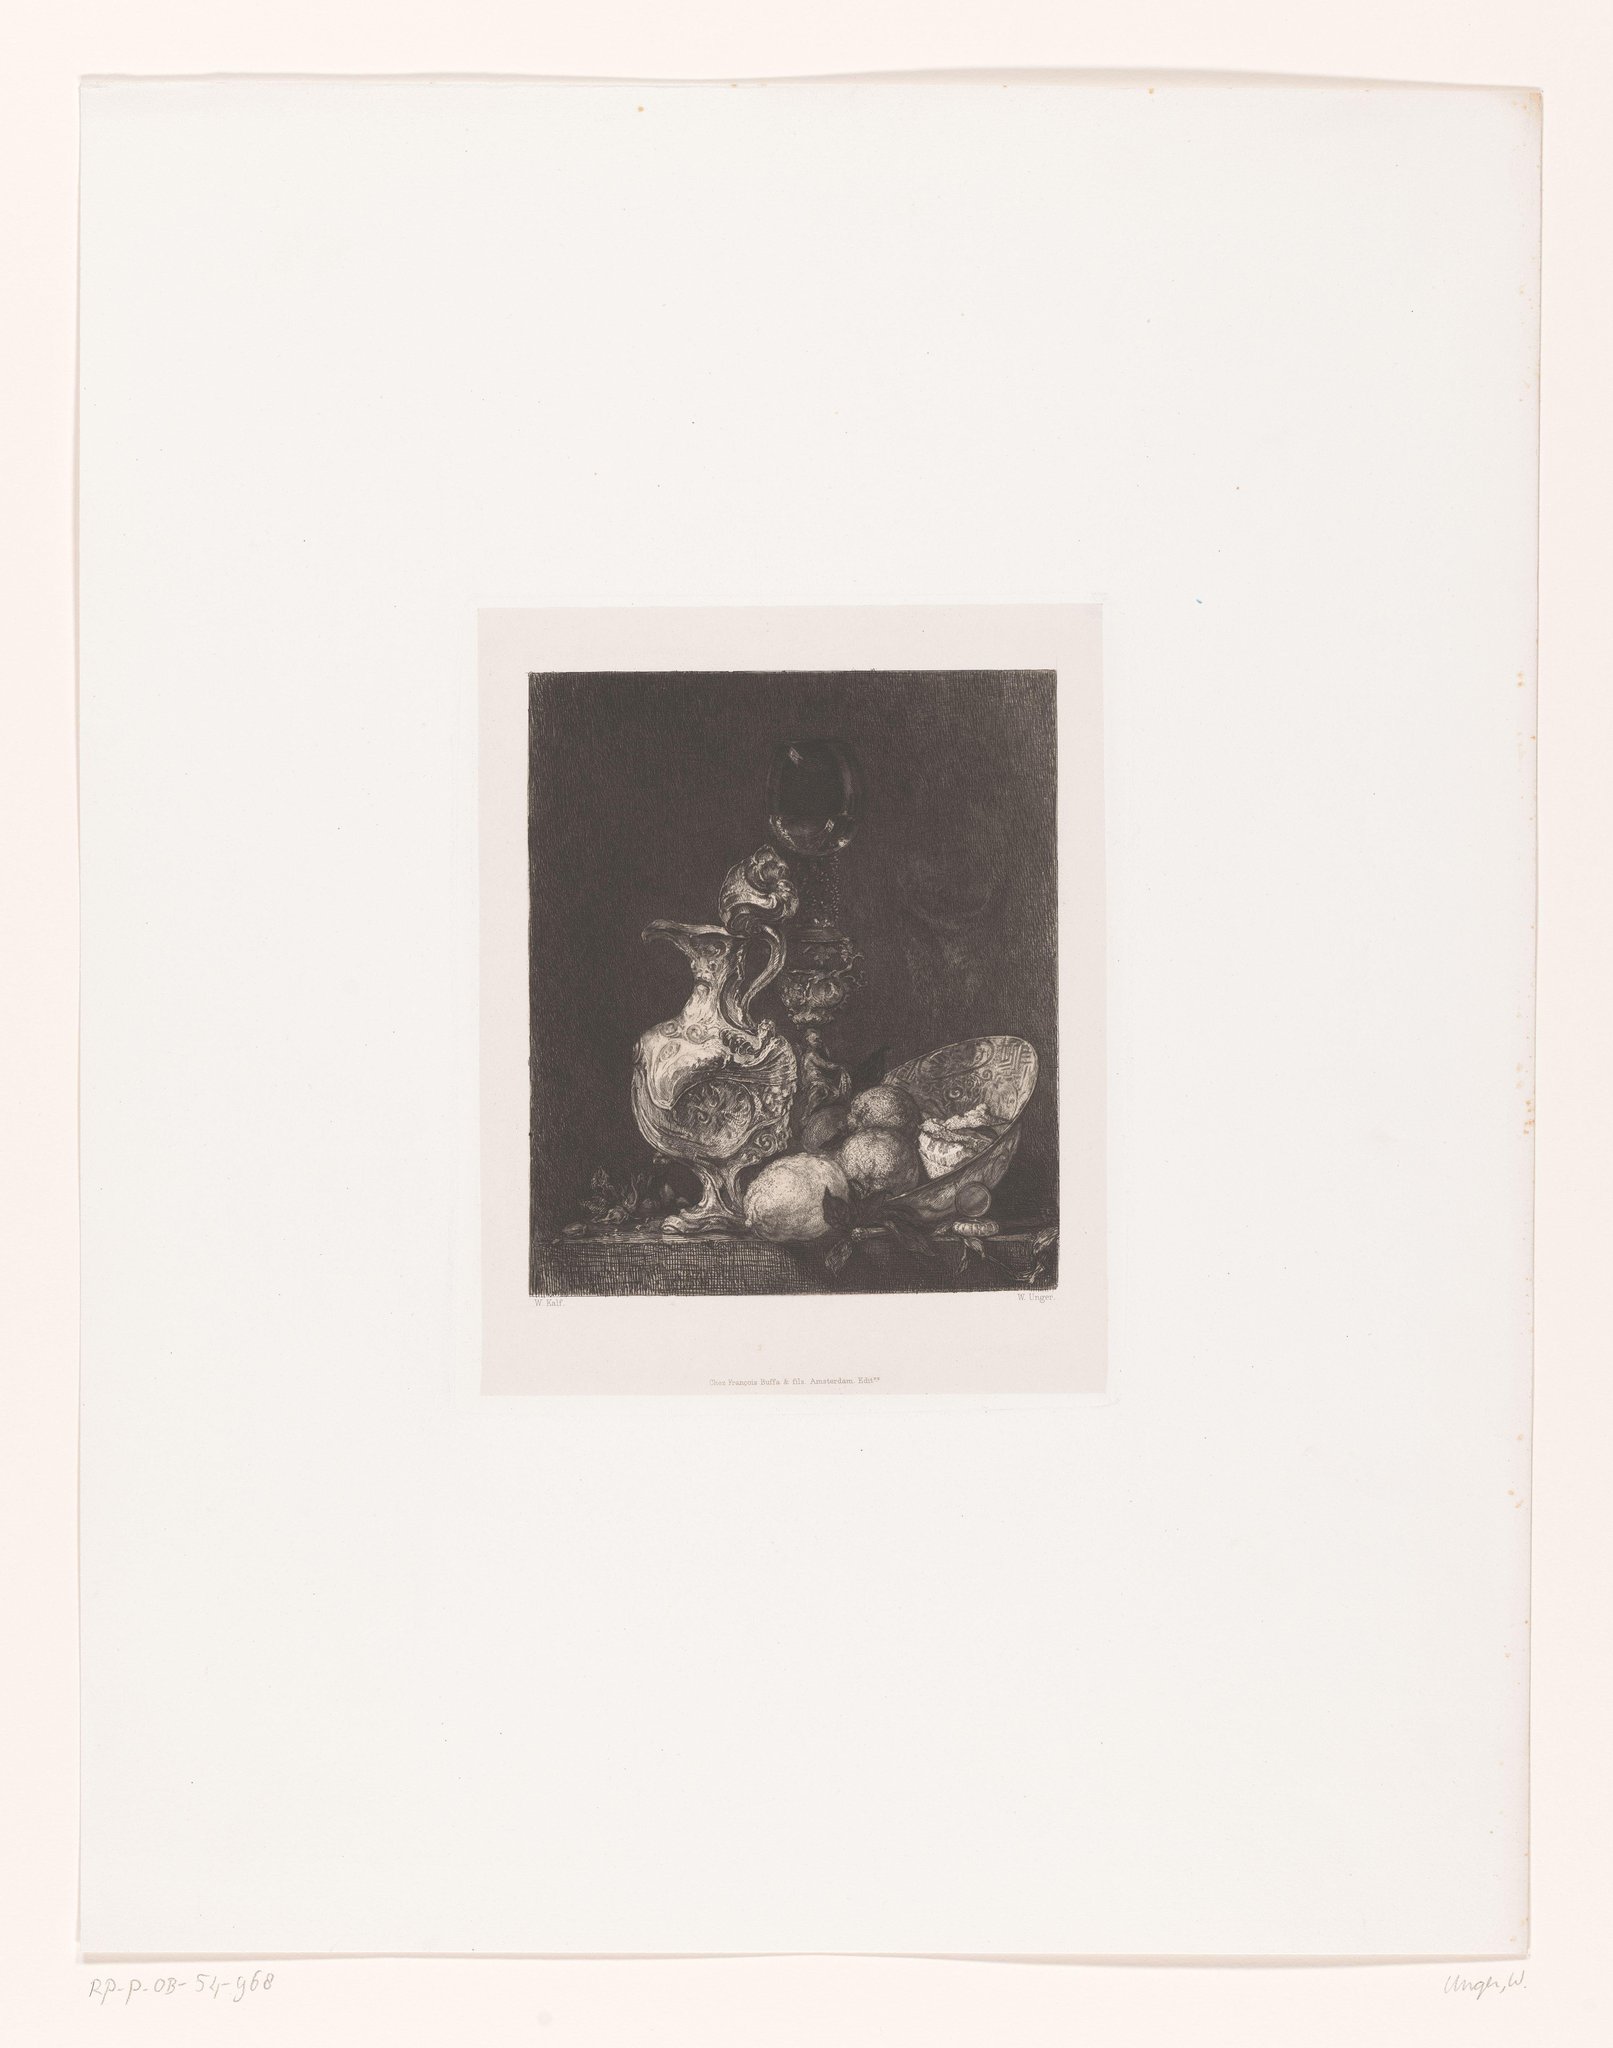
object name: print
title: Stilleven met zilveren schenkkan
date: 1847-1889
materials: paper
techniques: etching, intaglio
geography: germany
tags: glass of wine, watch, fruits: lemon, container of precious metal, still life of miscellaneous objects